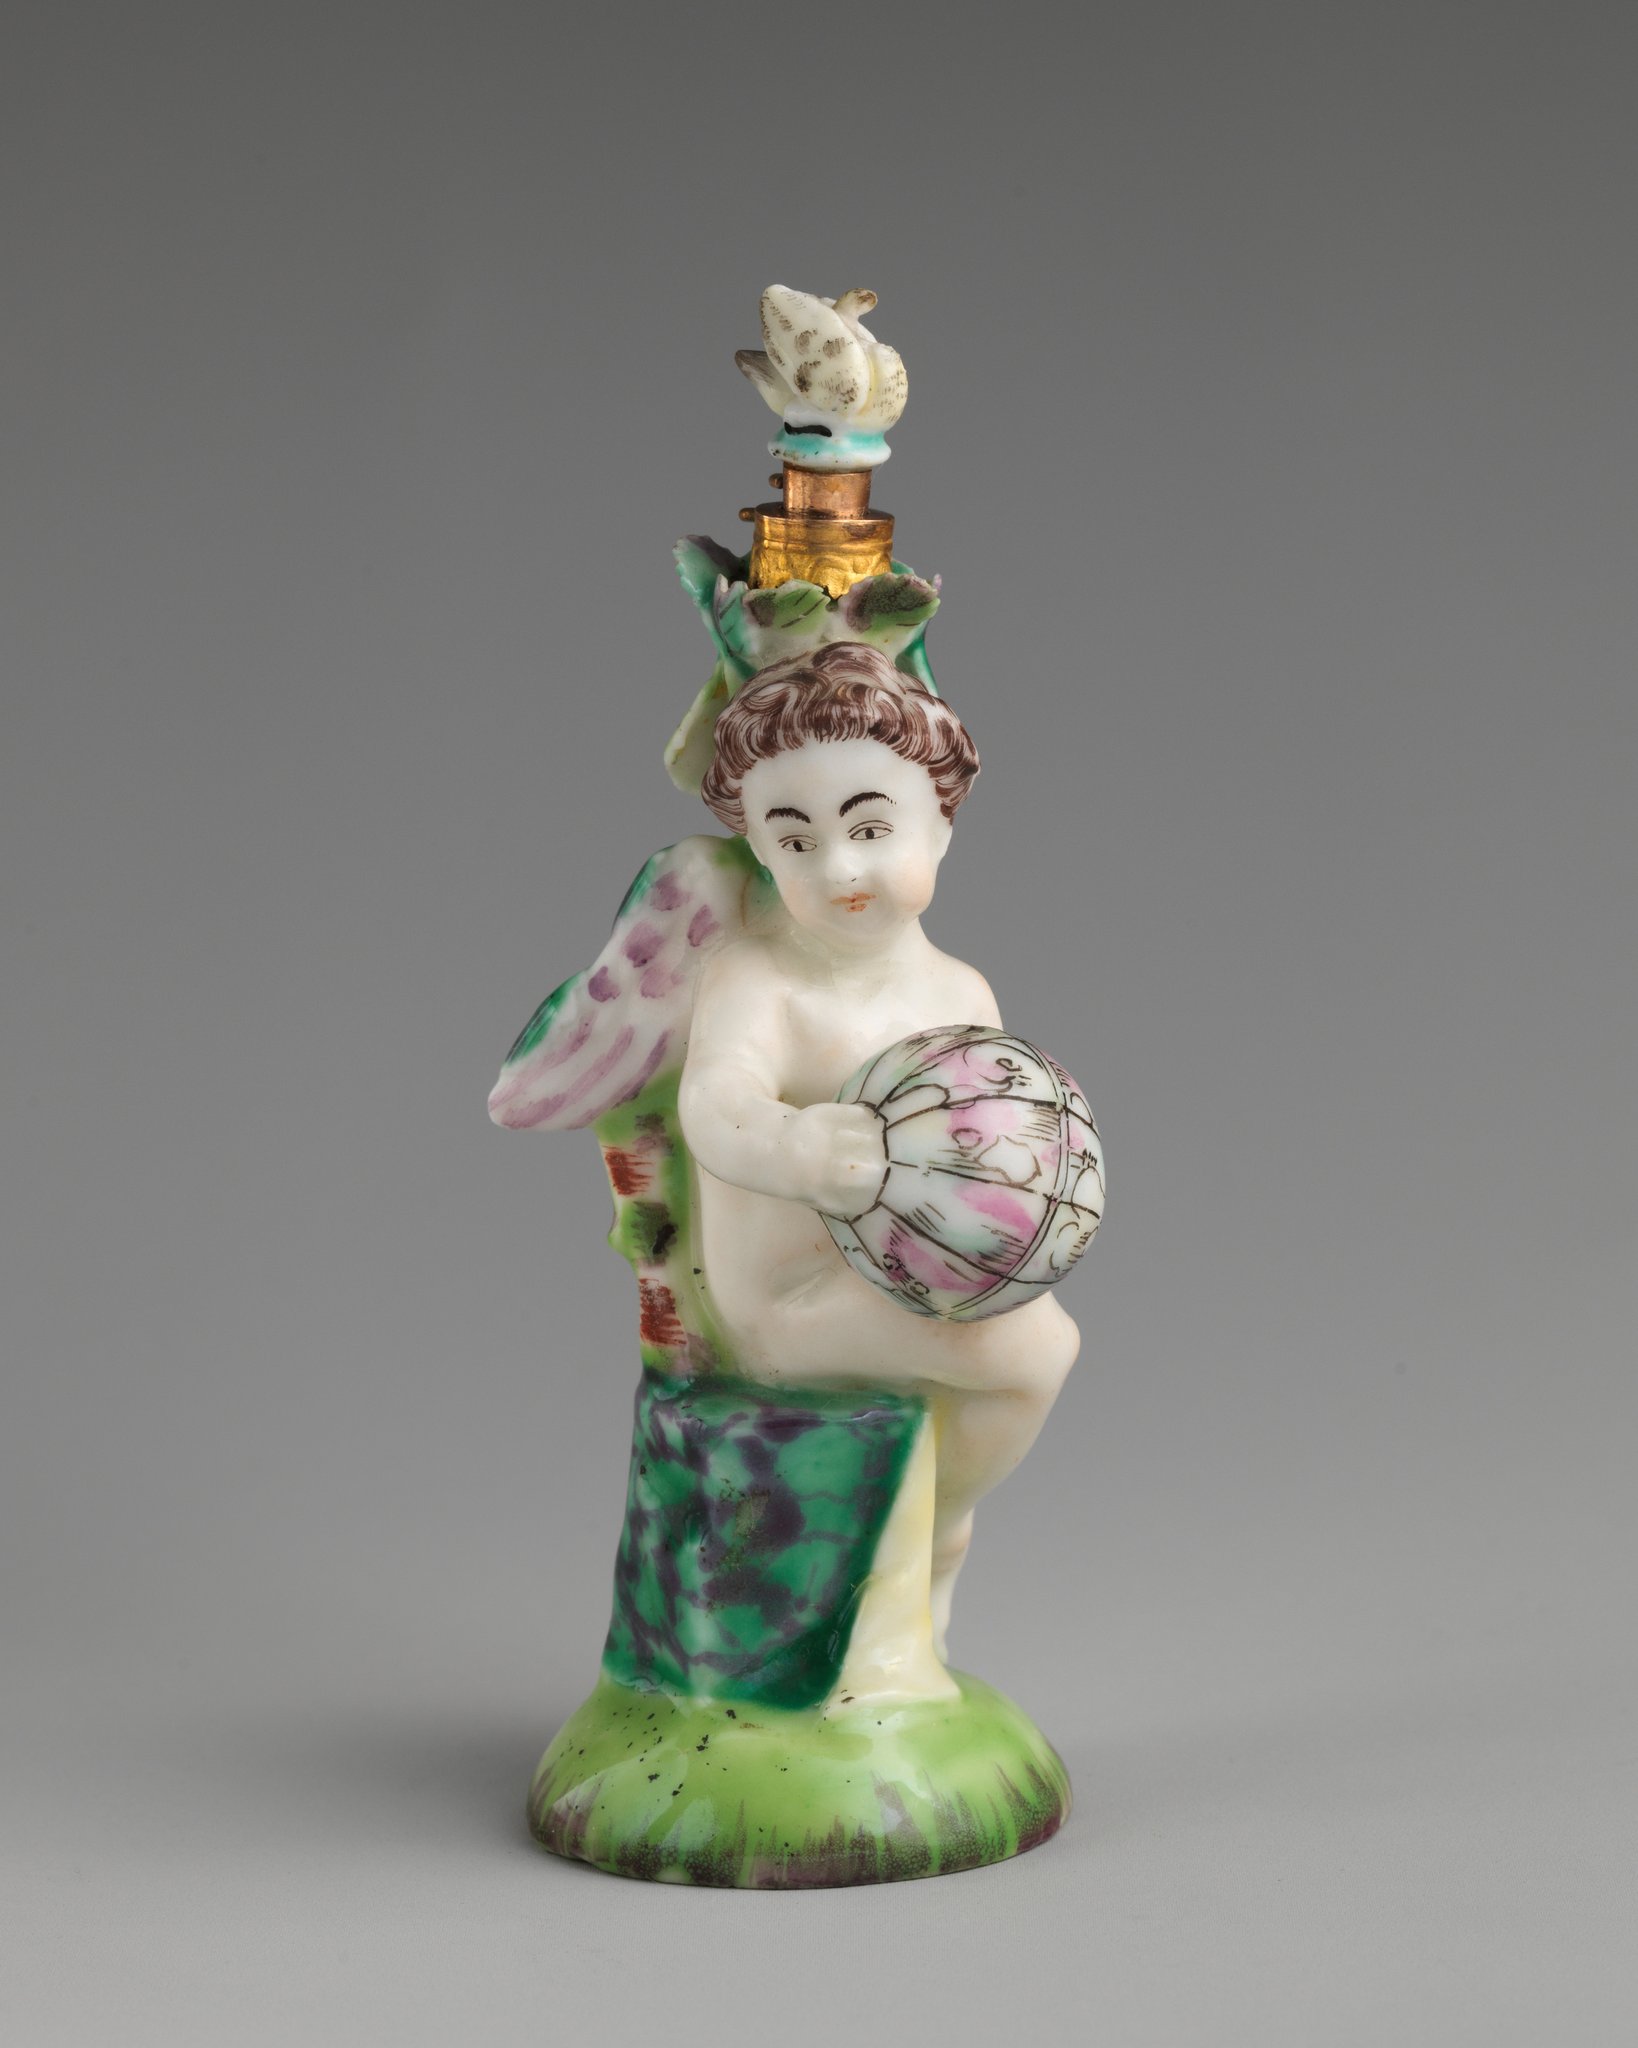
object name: toy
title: Cupid with globe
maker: saint james's factory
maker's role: maker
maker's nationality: british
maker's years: 1749-1759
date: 1760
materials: soft paste porcelain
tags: cupid,globes